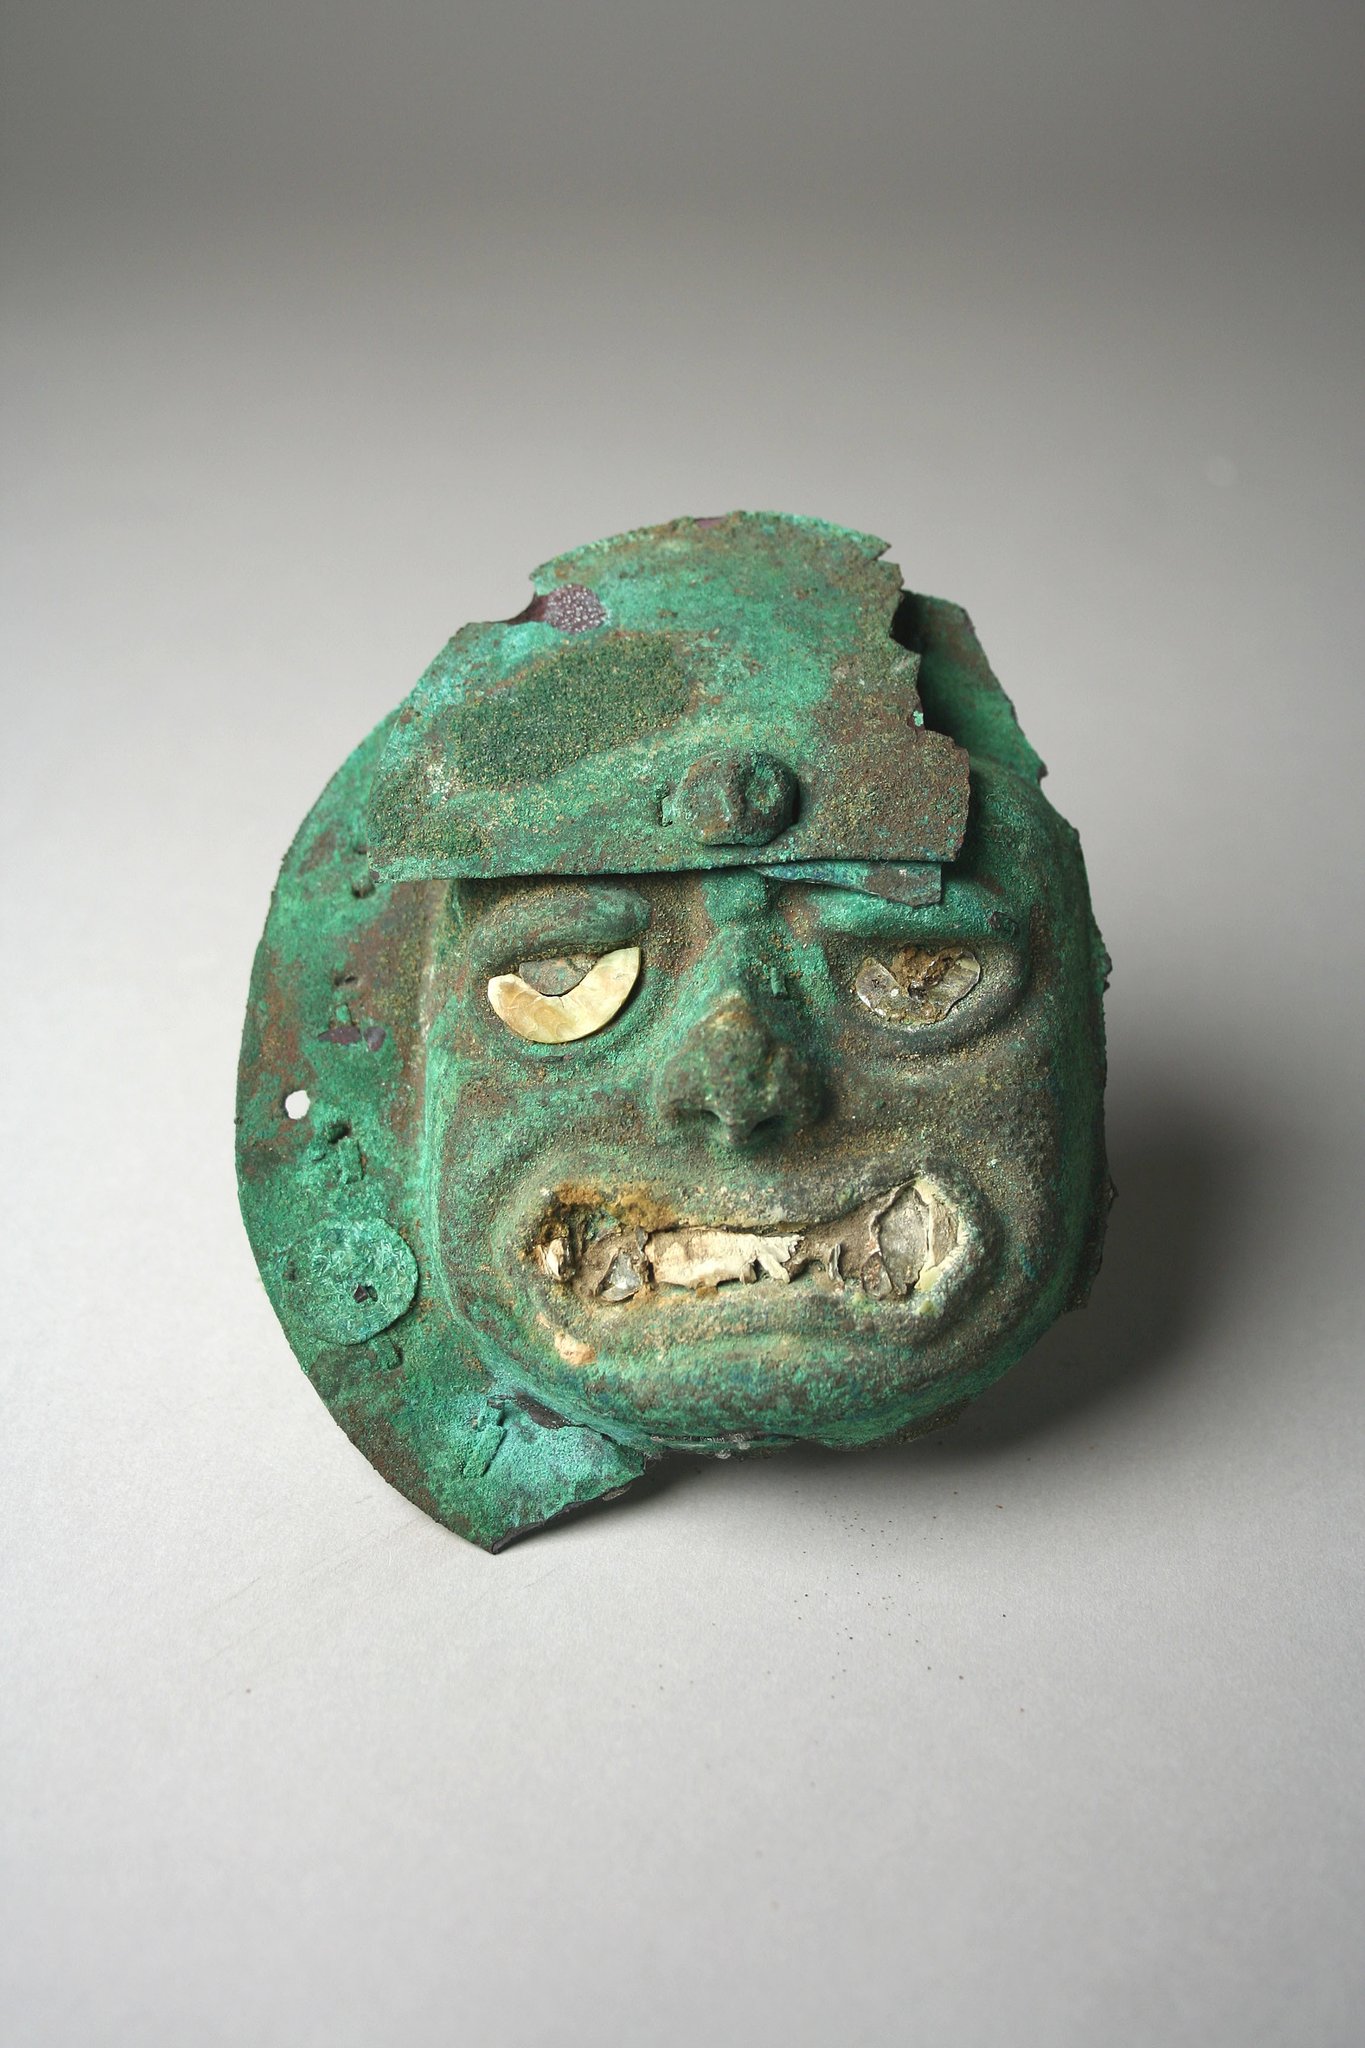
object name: ornament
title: Face Mask Ornament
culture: moche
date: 501-700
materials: shell, metal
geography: peru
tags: masks